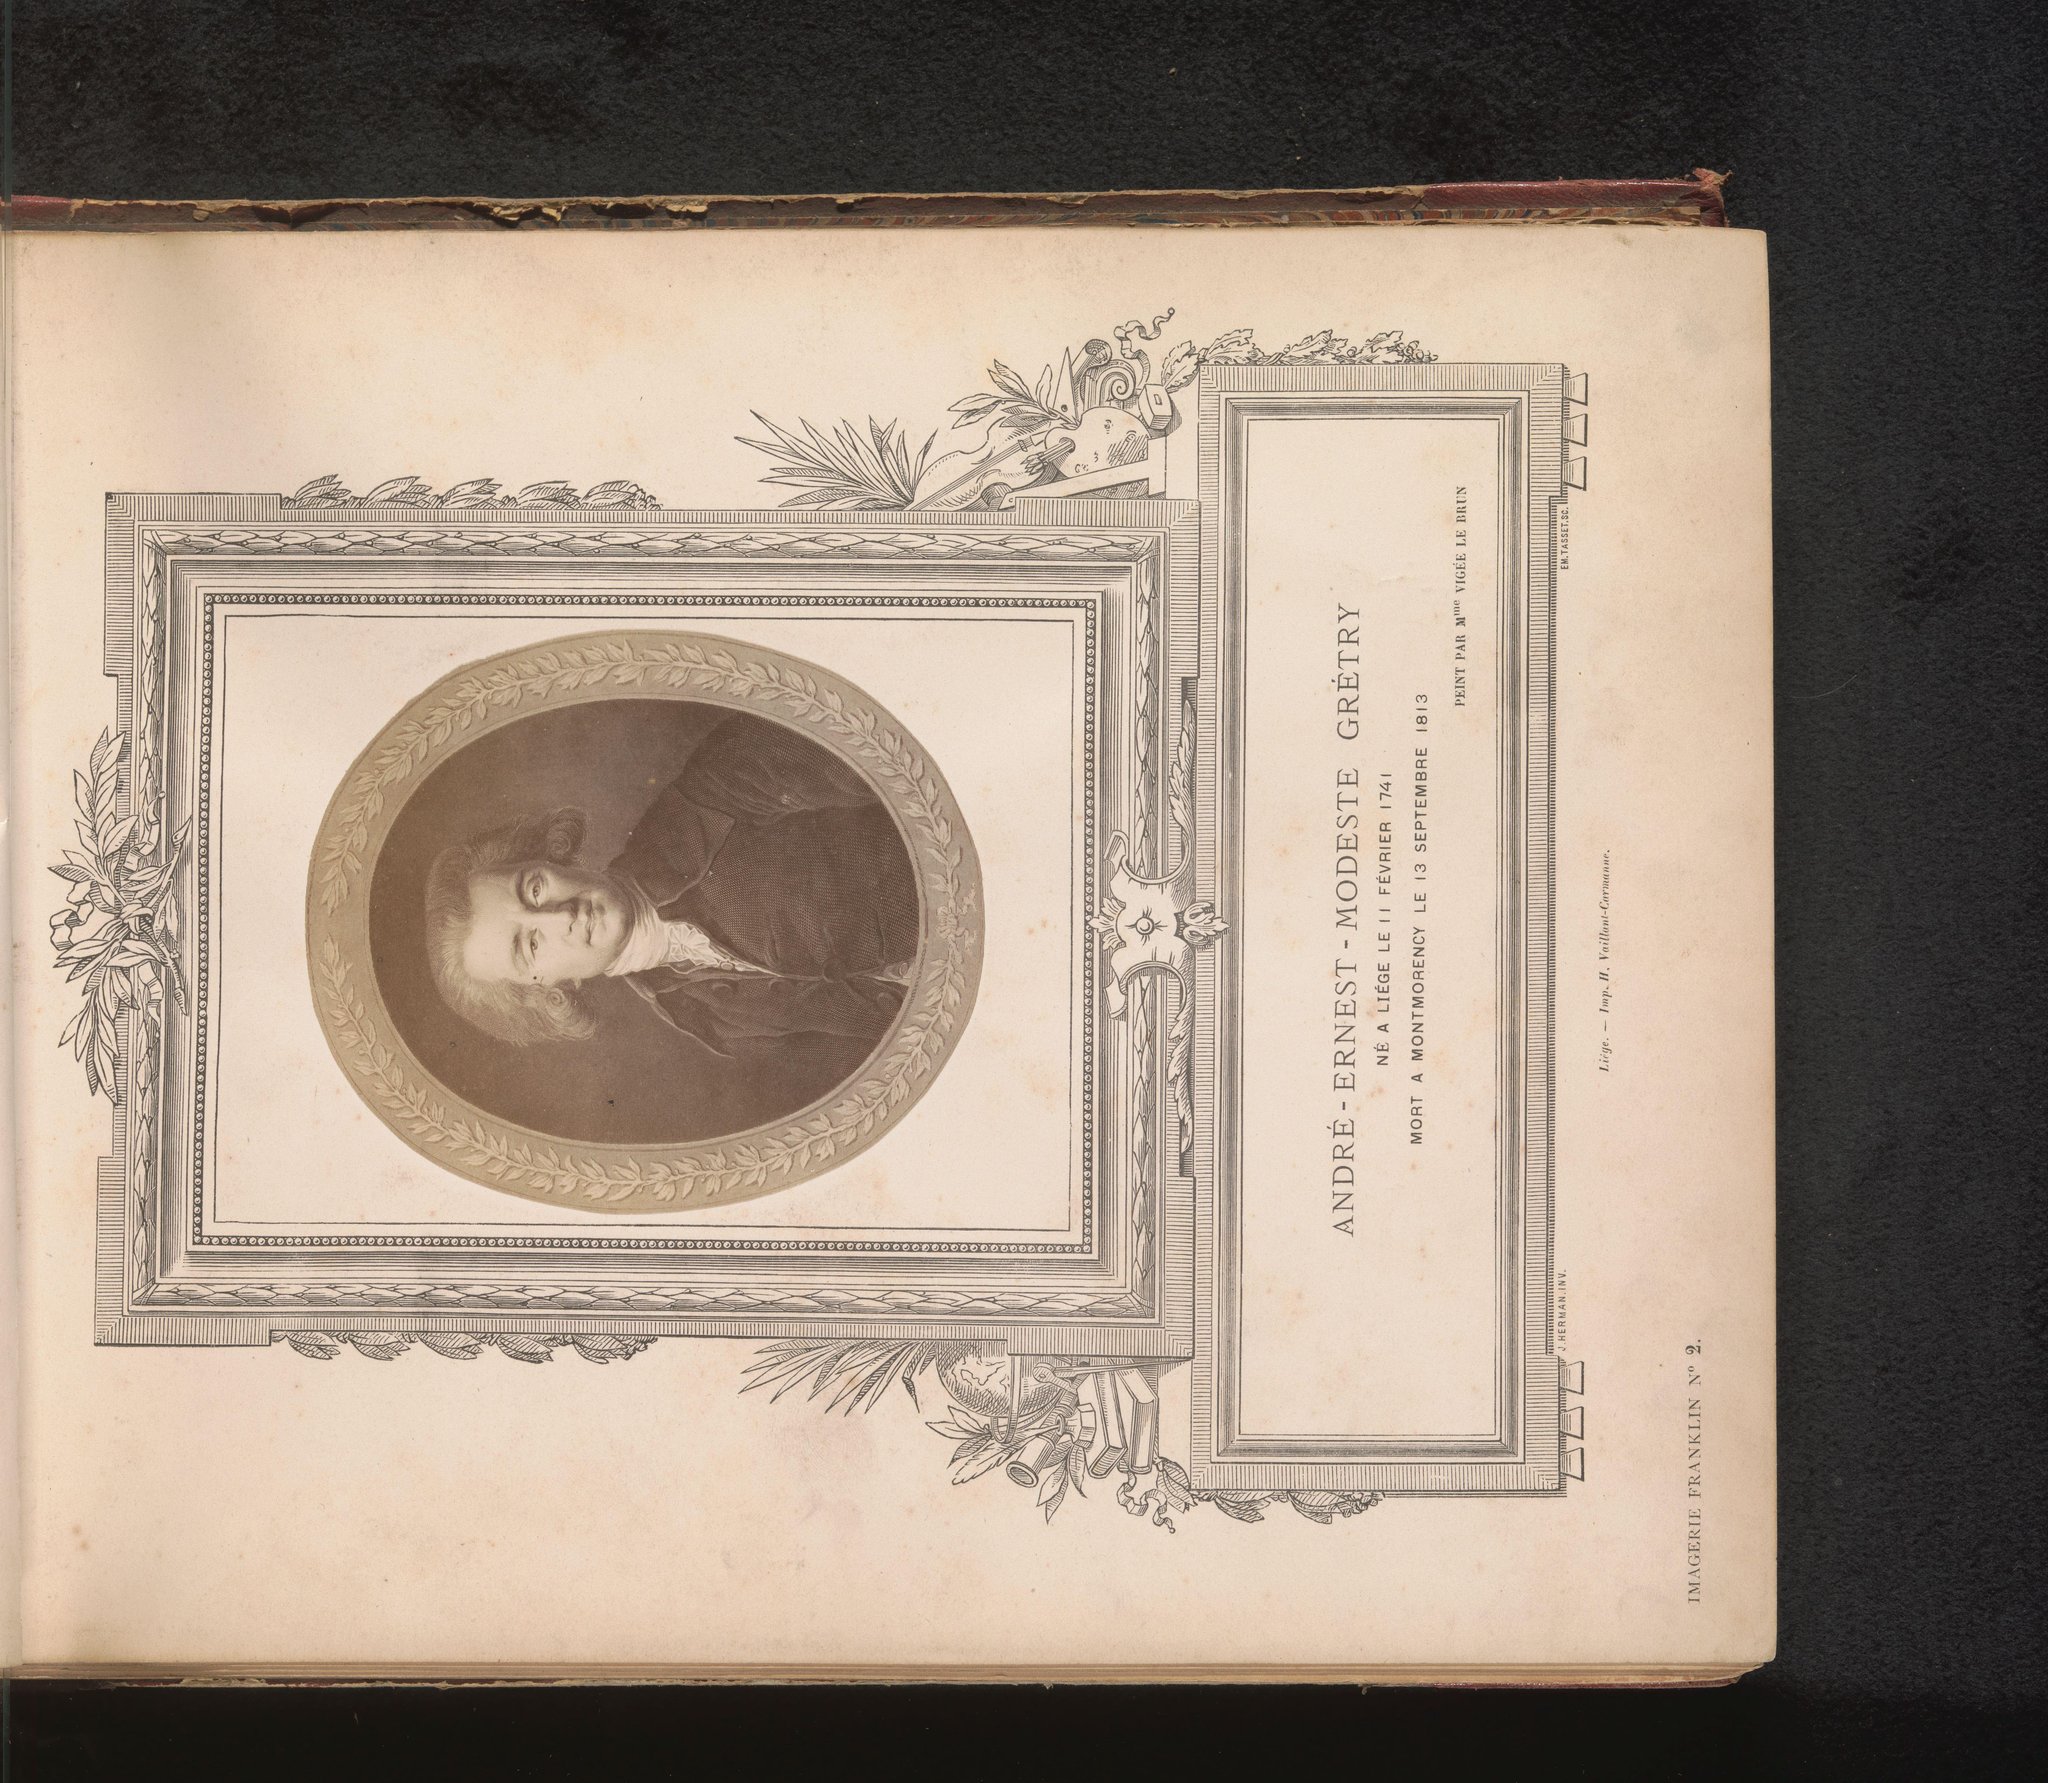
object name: reproduction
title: André-Ernest-Modeste Grétry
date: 1871-1880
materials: photographic support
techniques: albumen print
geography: liège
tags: liège, historical persons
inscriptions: name: ‘J. HERMAN, INV.’, inscription: ‘NÉ À LIÈGE LE 11 FÉVRIER 1741/ MORT À MONTMORENCY LE 13 SEPTEMBRE 1813’, name: ‘EM. TASSET, SC.’, inscription: ‘IMAGERIE FRANKLIN No 2.’